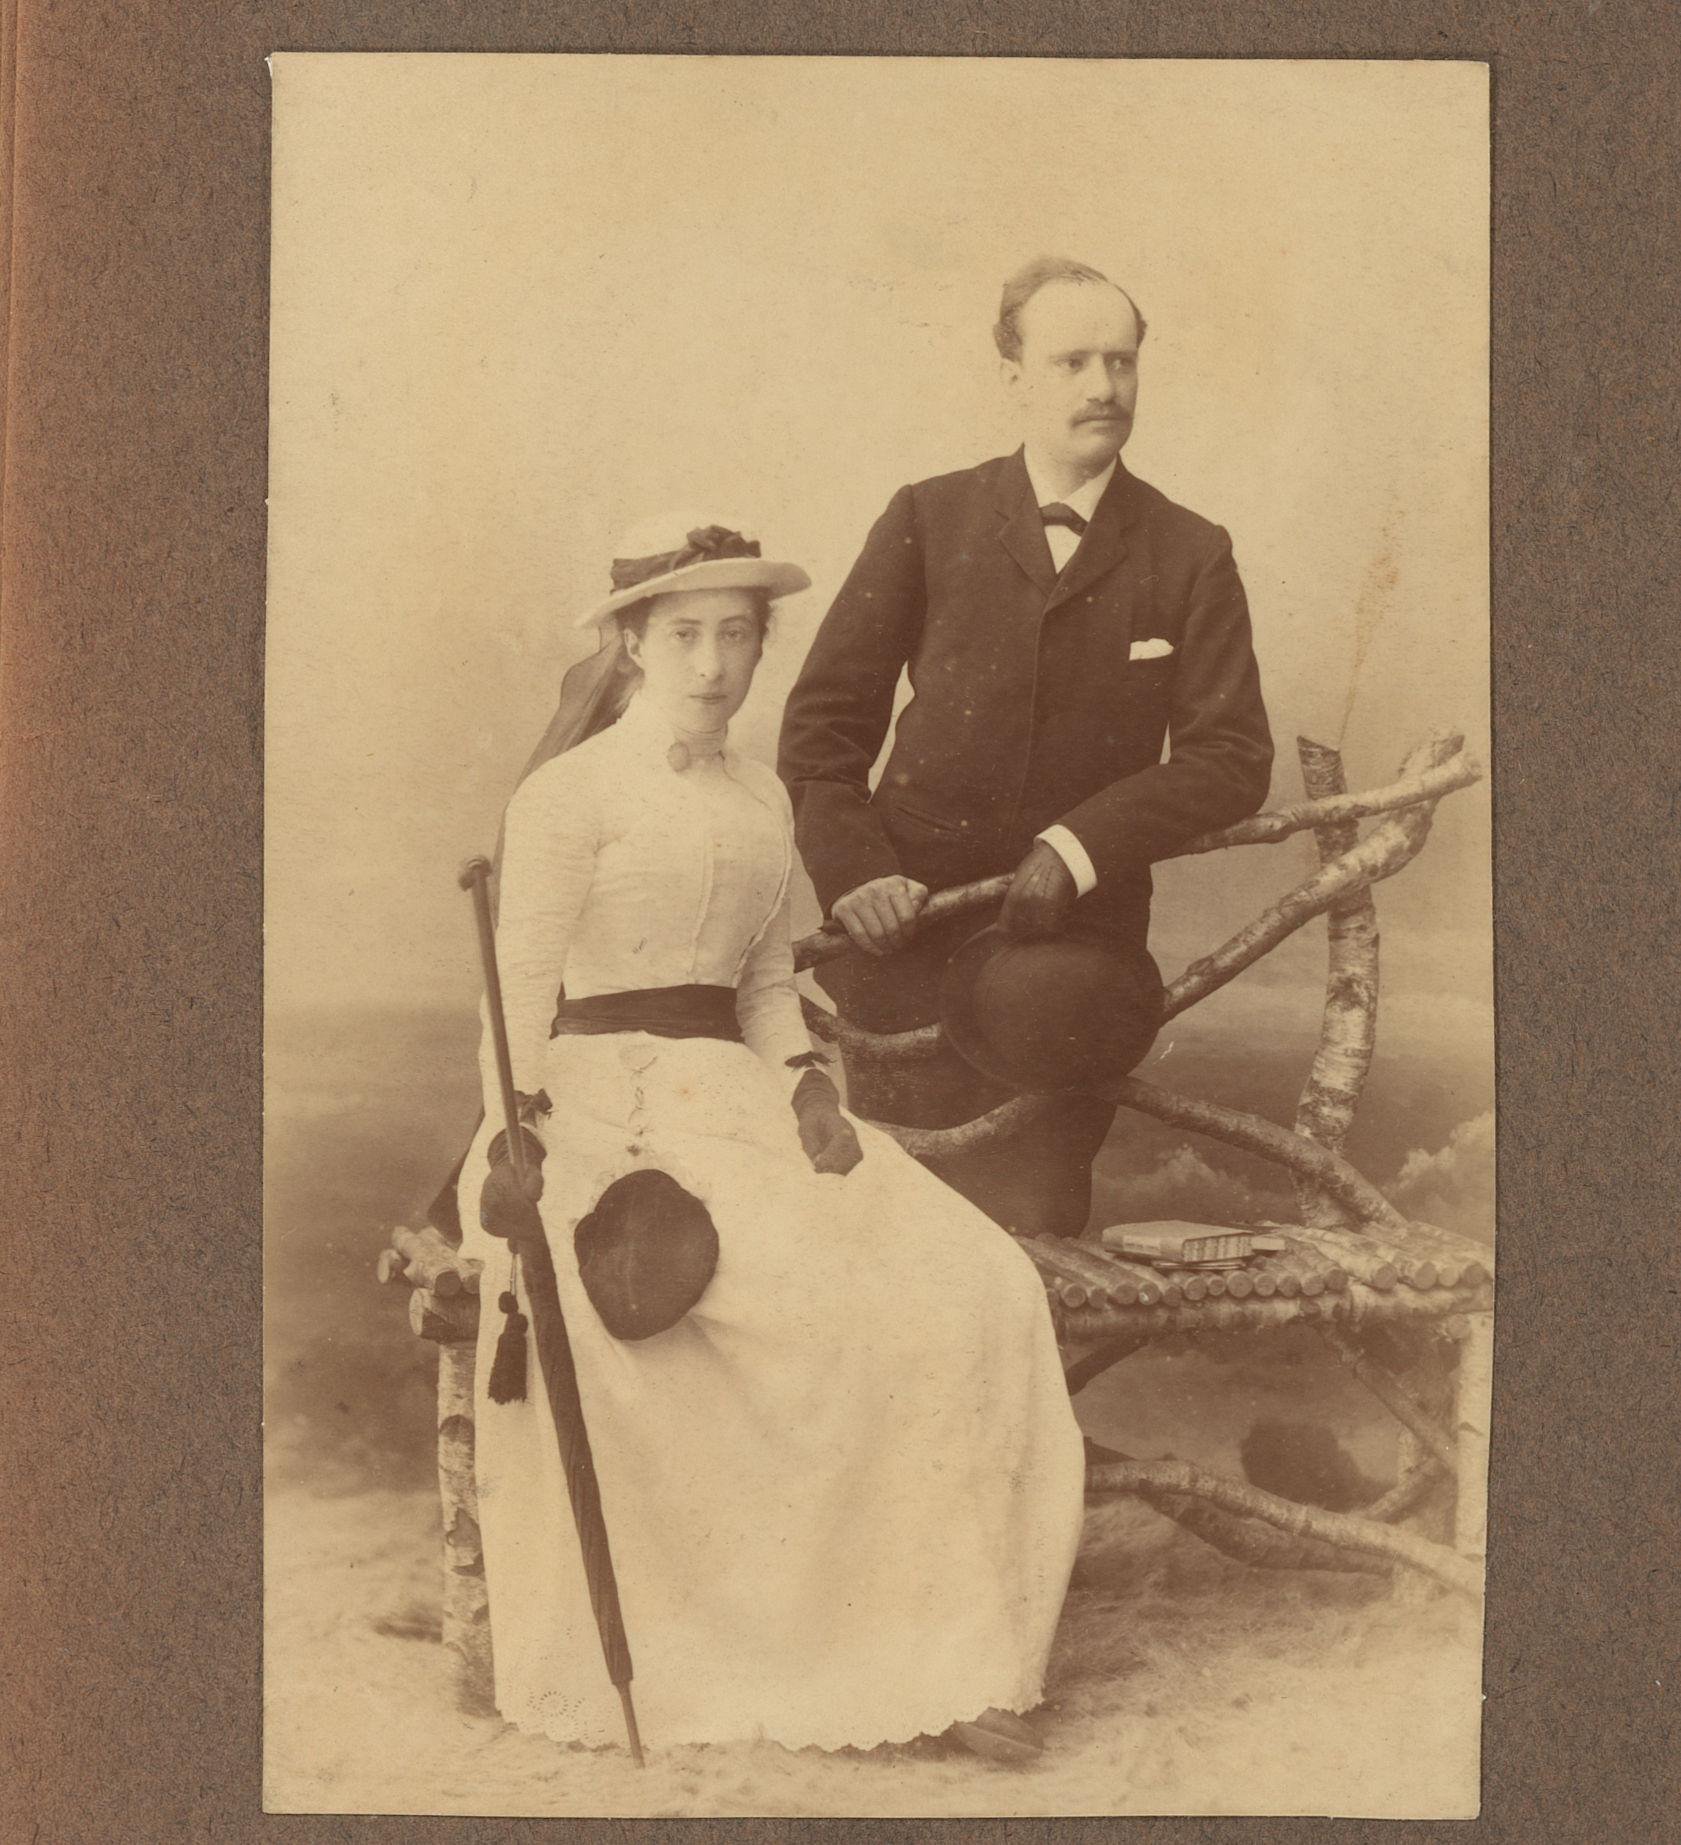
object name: photograph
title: Studioportret van vrouw en man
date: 1870-1920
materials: photographic support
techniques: photography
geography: netherlands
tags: netherlands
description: Foto op bruin albumblad 34 van familiealbum van Alphons Diepenbrock.